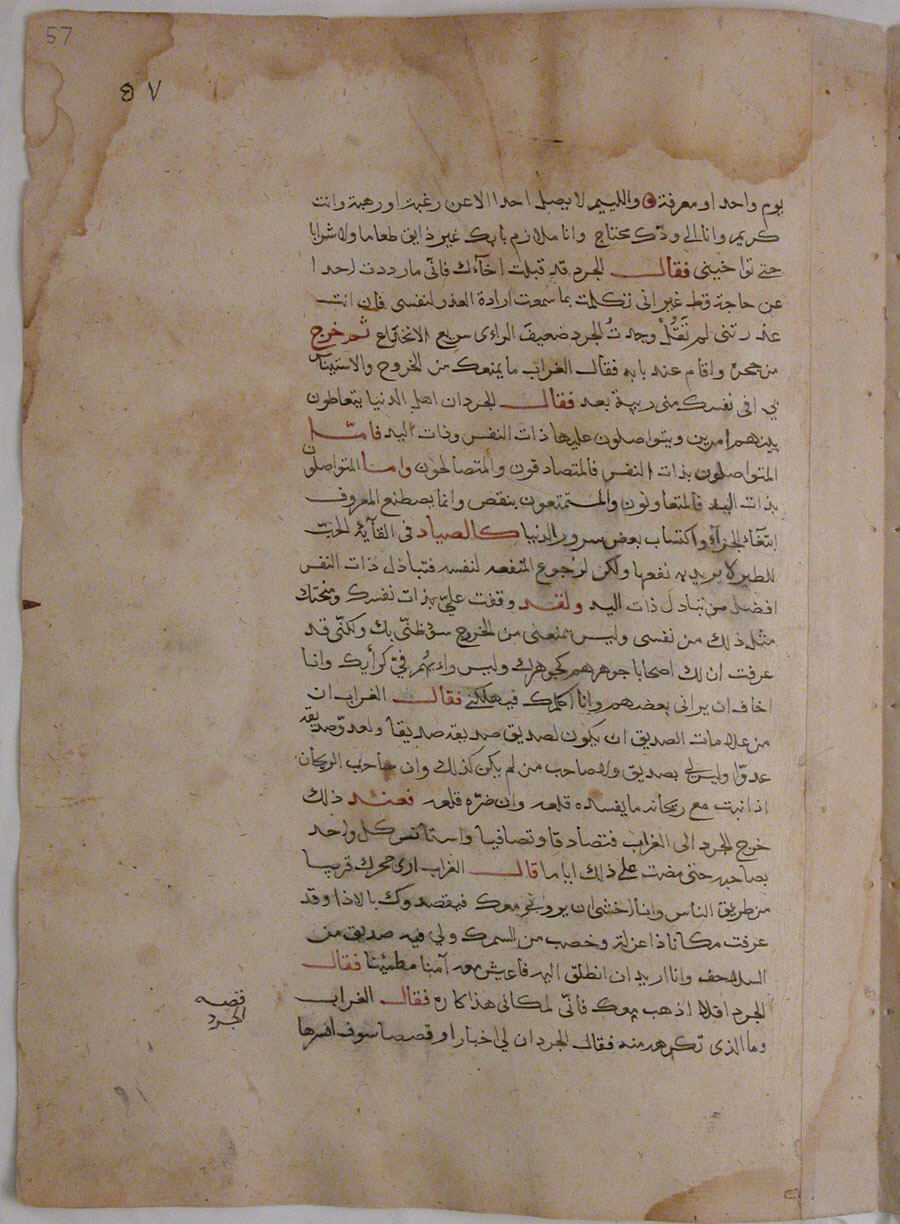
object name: folio from an illustrated manuscript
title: Page of Calligraphy from a Kalila wa Dimna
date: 1526-1550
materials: ink, paper, watercolor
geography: india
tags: arabic,calligraphy